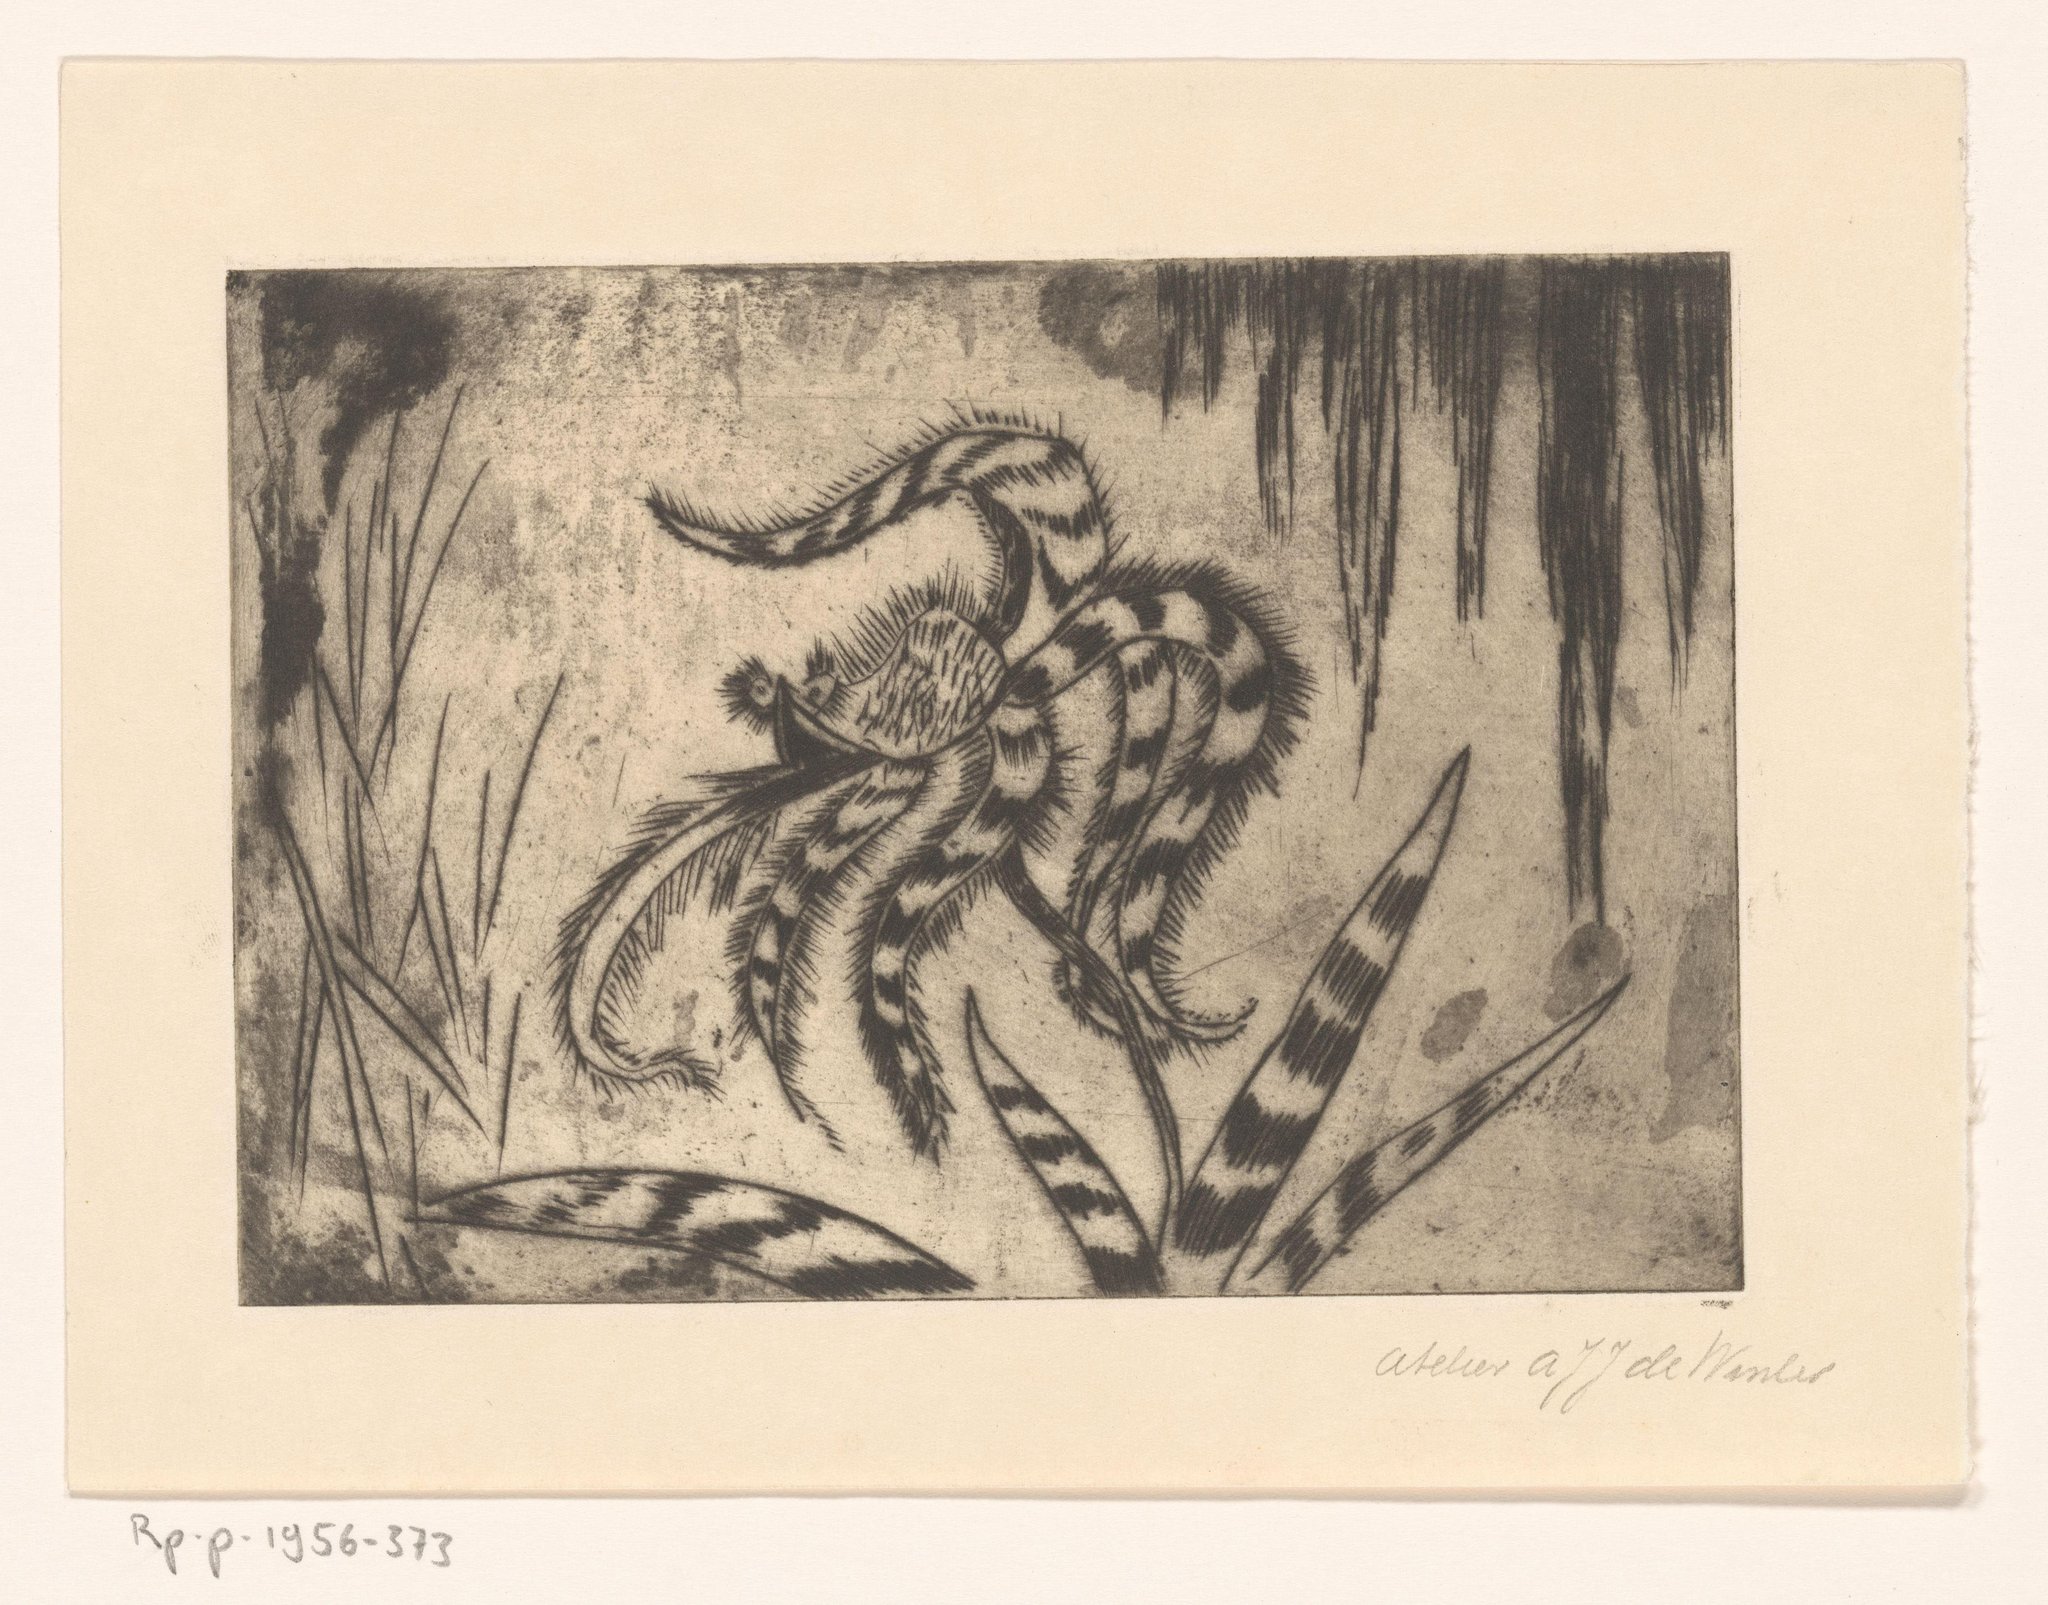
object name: print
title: Orchidee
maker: janus de winter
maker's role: print maker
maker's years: 1882-1951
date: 1892-1951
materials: paper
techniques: drypoint, intaglio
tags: flowers: orchid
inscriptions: inscription: ‘Atelier van AJJ de Winter’, collector's mark: Lugt 2228